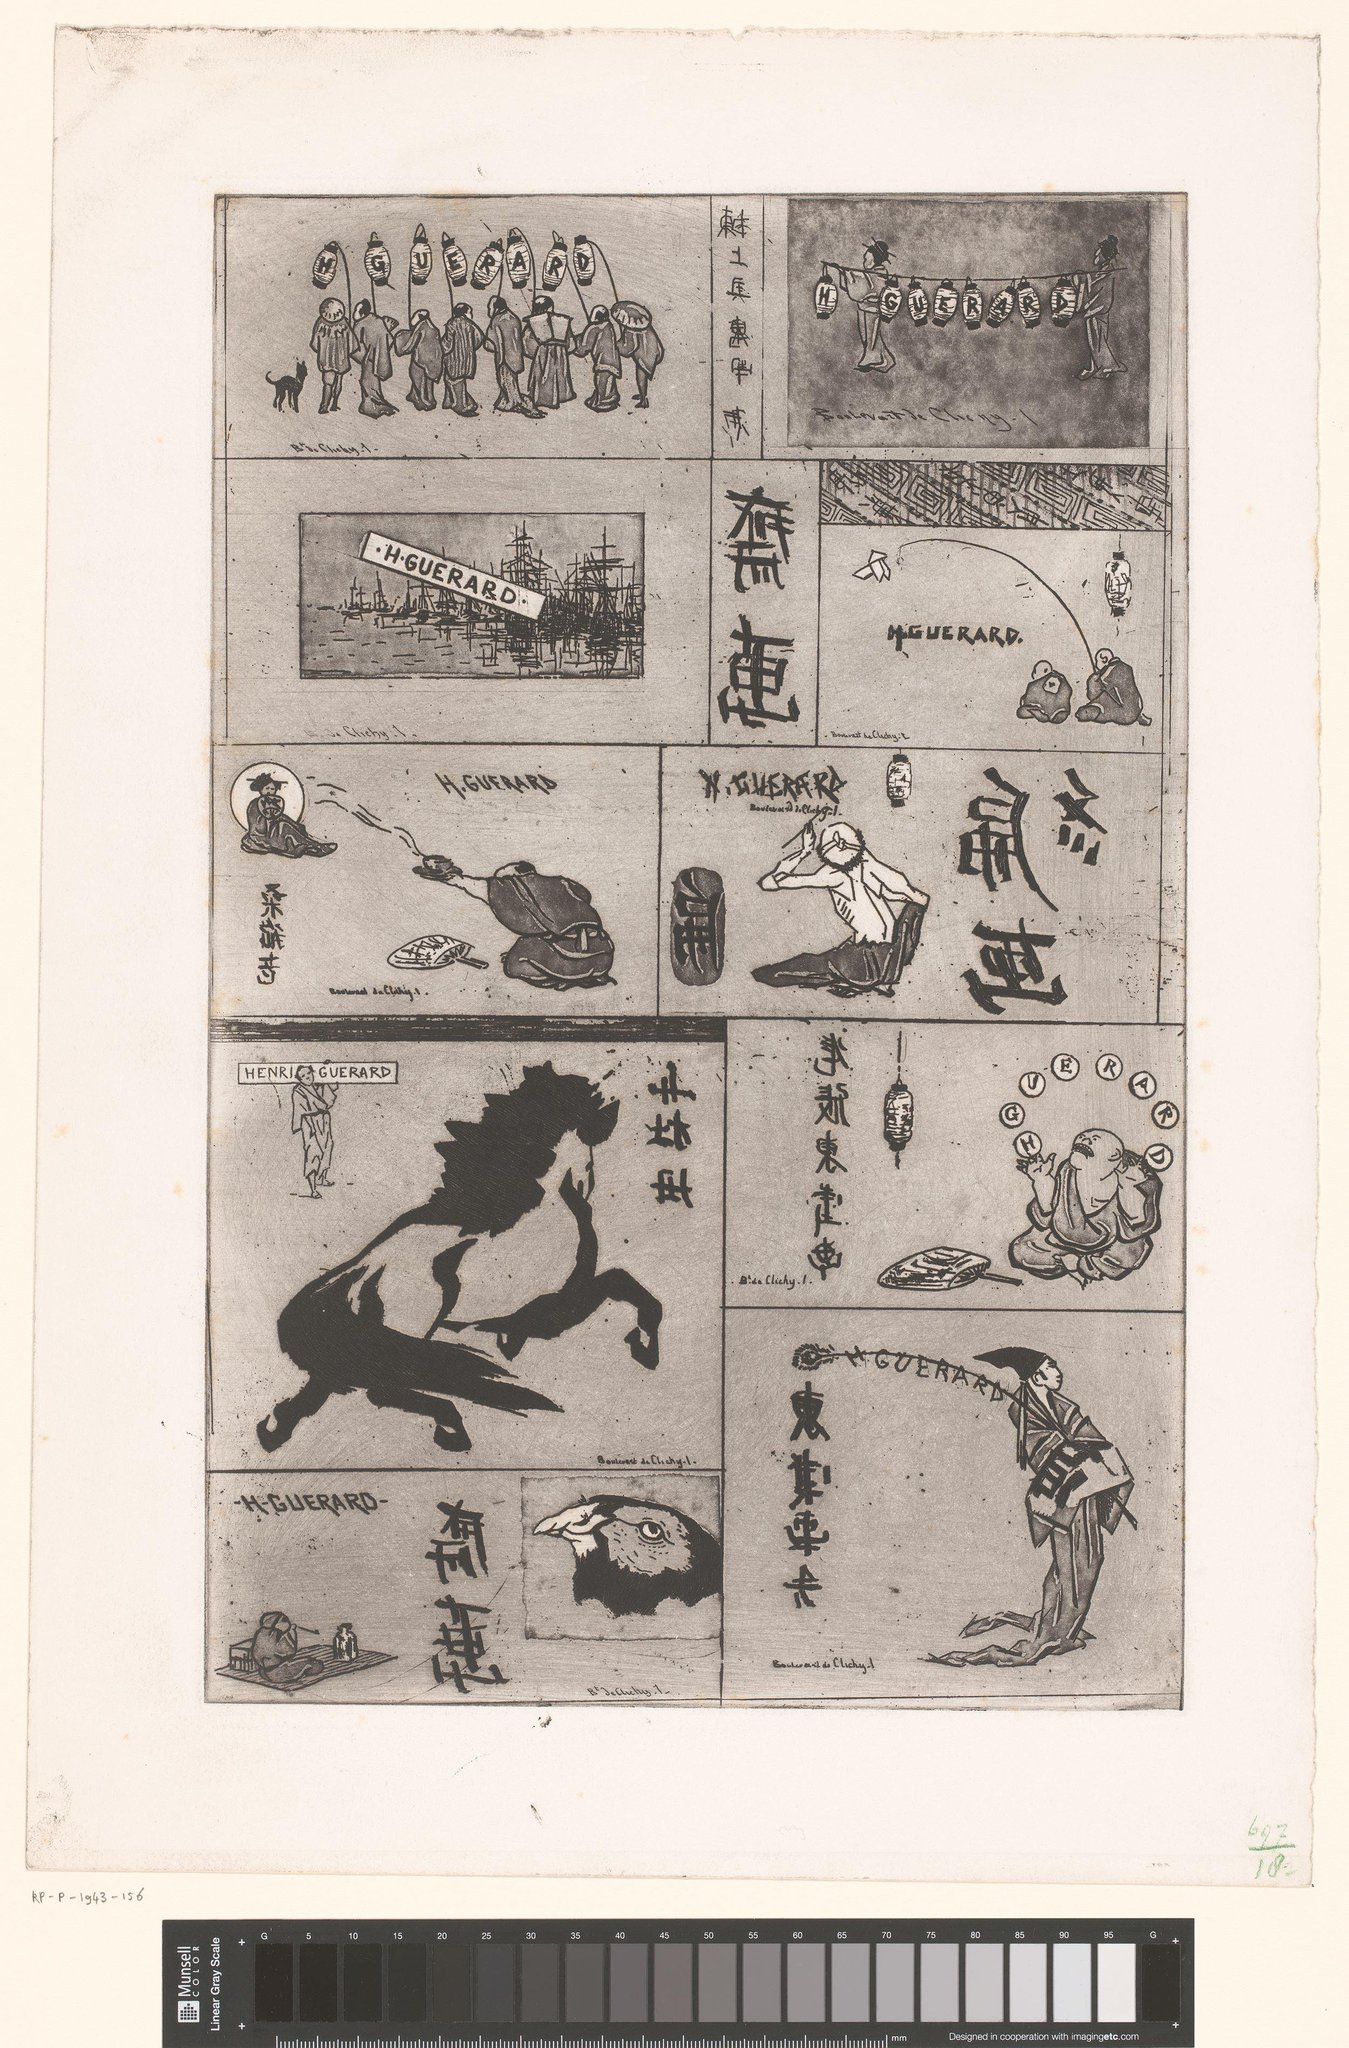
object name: visiting card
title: Compositie met tien voorstellingen, mogelijk adreskaarten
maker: henri charles guérard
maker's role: print maker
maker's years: 1846-1897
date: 1856-1897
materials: paper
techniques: aquatint, etching, intaglio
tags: lantern, horse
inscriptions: collector's mark: Lugt 2228